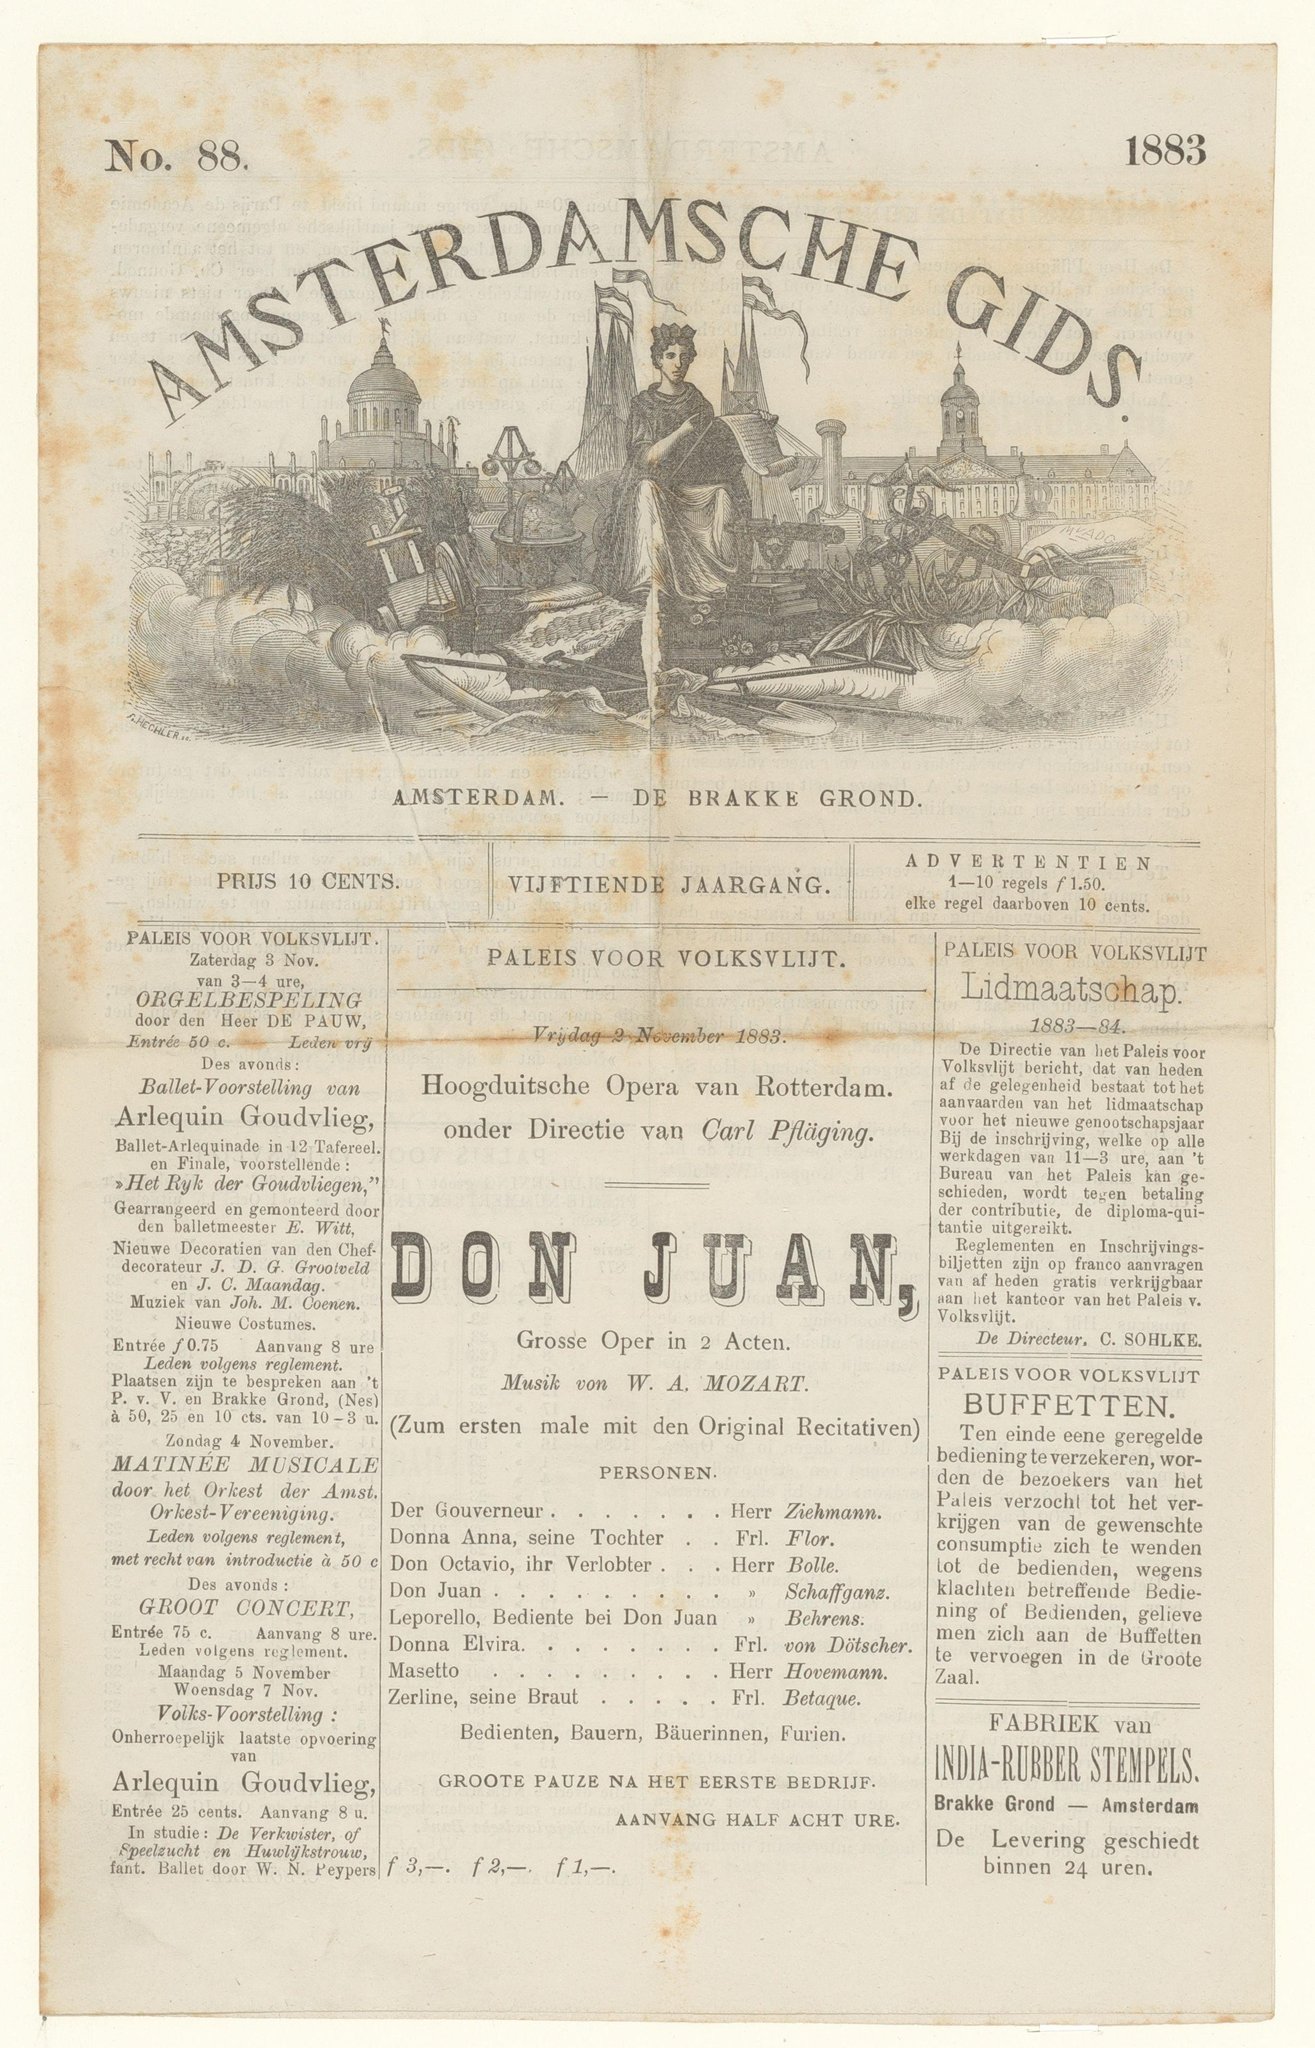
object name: print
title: Amsterdamsche Gids met aankondiging van de voorstelling Don Juan, 1883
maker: Anonymous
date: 1883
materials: paper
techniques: letterpress printing, engraving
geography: amsterdam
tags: theatre, theatrical performance, advertisement, notice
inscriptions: stamp, collector's mark: Lugt 1641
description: Een gevouwen blad vormt vier pagina's. Op de eerste pagina een aankondiging van de aankomende voorstelling Don Juan in de Stadsschouwburg in 1883. Op de overige pagina's advertenties. Linksboven genummerd: No. 88. Onderwerpsrubrieken binnen de Atlas Zeden en Gewoonten: Tooneel, Toneelprogramma’s.